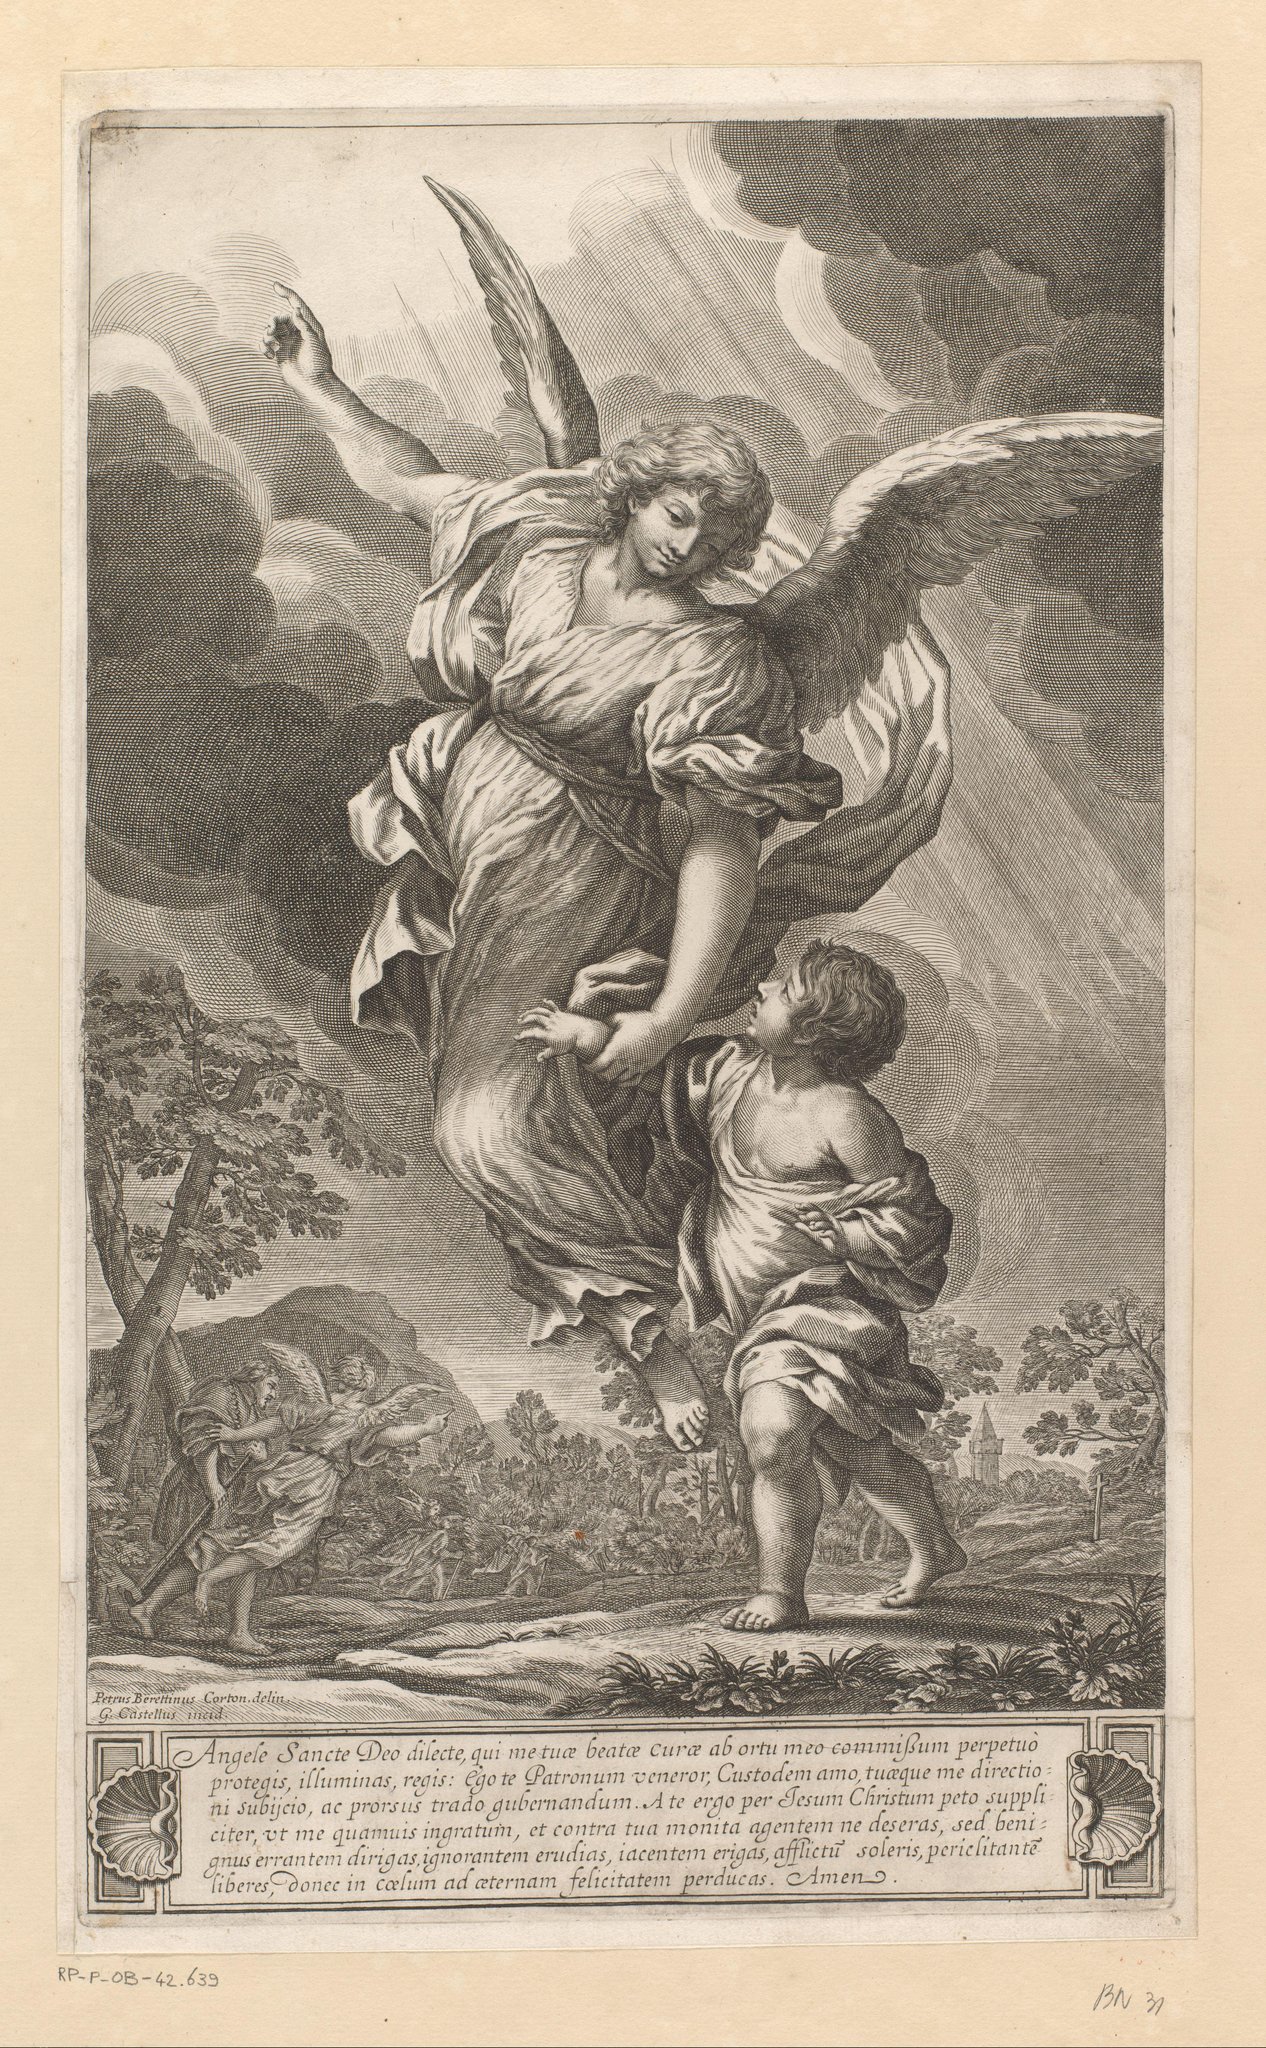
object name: print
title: Beschermengel neemt een kind bij de hand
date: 1645-1683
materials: paper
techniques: engraving, etching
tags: guardian angel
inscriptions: collector's mark: Lugt 240